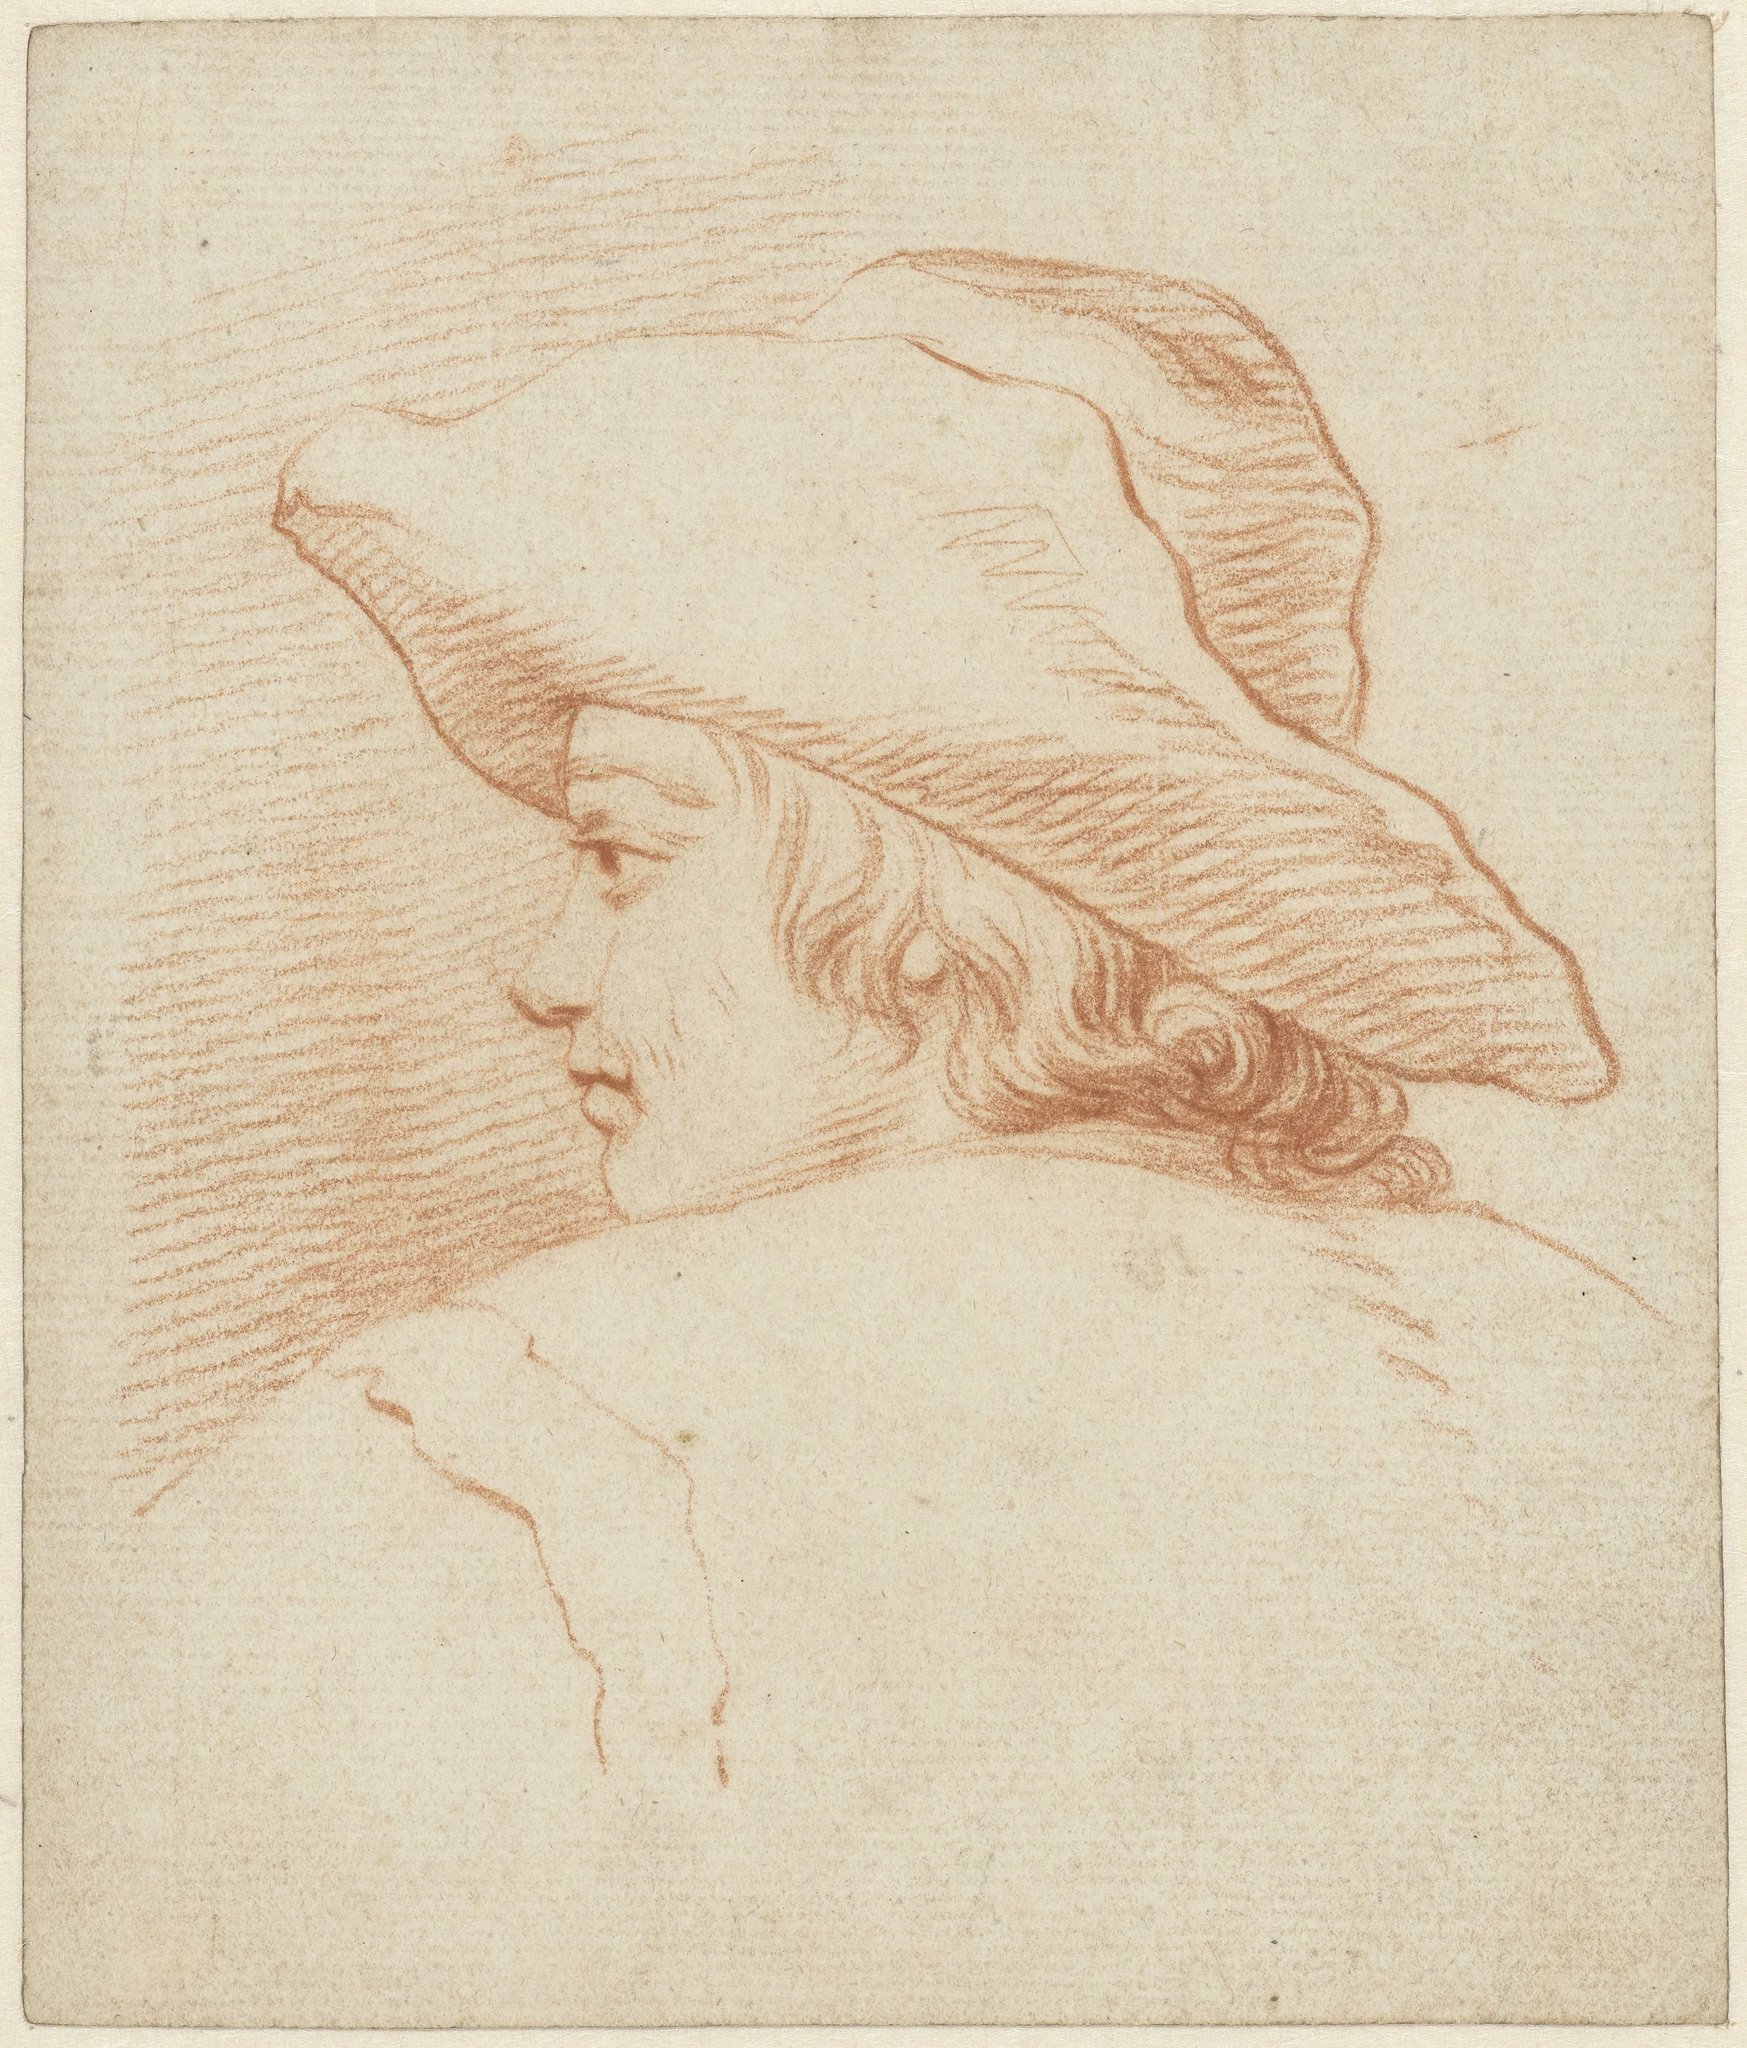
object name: drawing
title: Kop van een jongen met een grote hoed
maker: jordanus hoorn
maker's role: draughtsman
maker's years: 1753-1833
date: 1763-1833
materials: chalk, paper